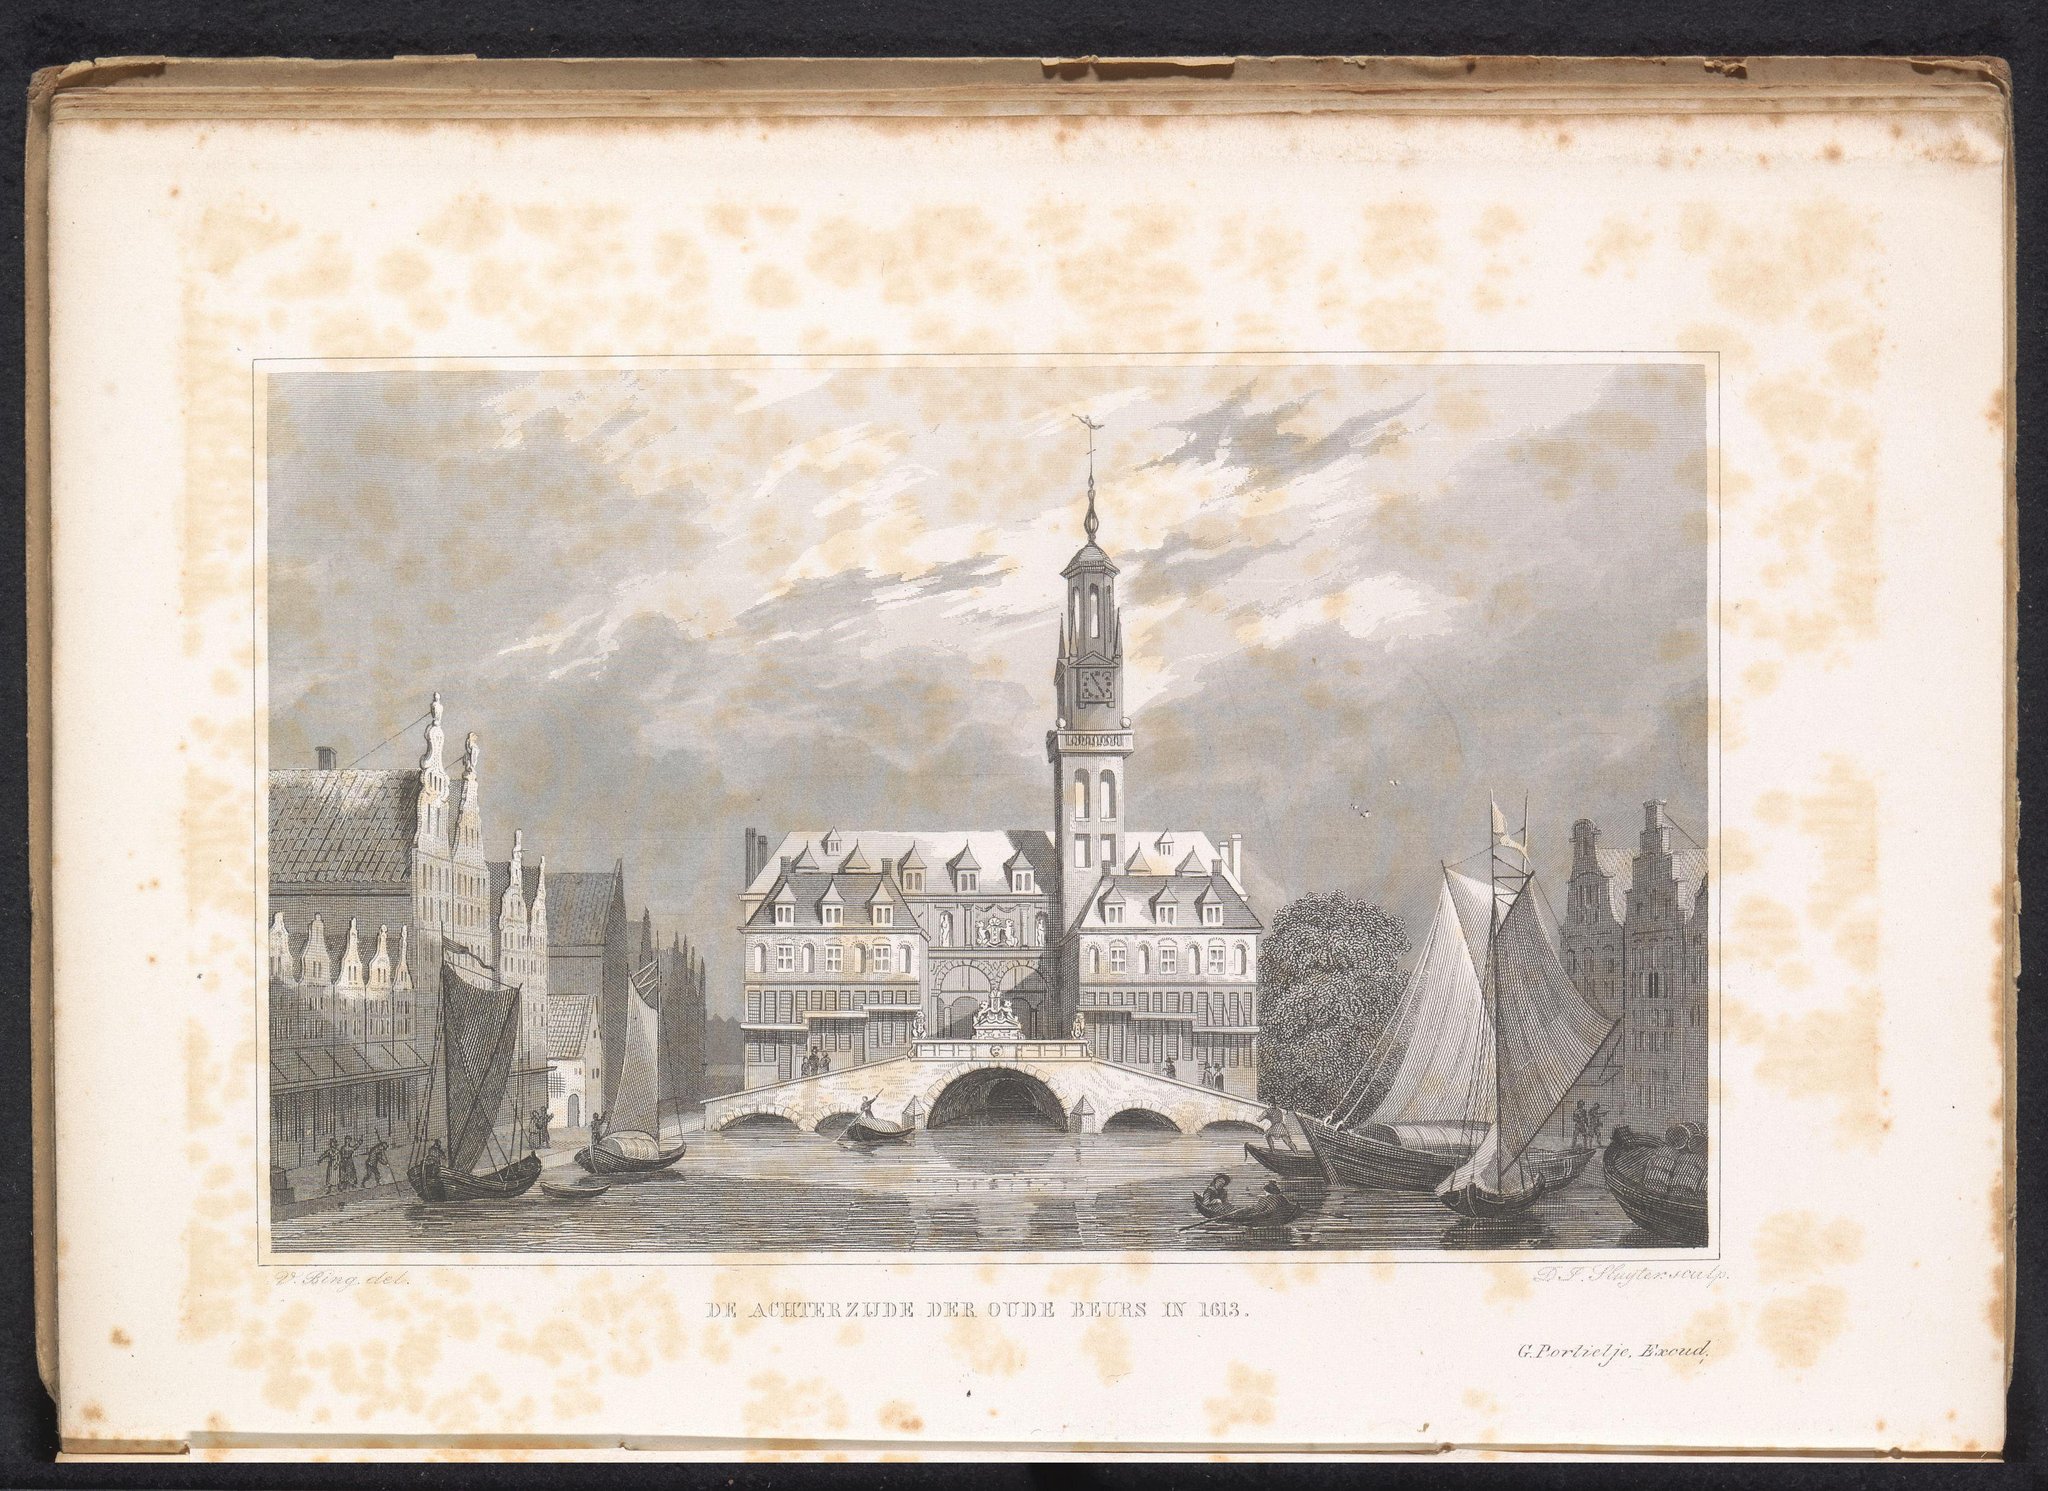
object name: print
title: Gezicht op de achterzijde van de Beurs van Hendrik de Keyser te Amsterdam, 1613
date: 1846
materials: paper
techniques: engraving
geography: netherlands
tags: sailing-ship, sailing-boat, stock exchange, stock-market, canals, waters (in city) (+ city(-scape) with figures, staffage)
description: Gezicht op de achterzijde van de oude beurs van Hendrik de Keyser te Amsterdam in 1613. Illustratie in een boek uit 1846 over de oude en nieuwe beurs van Amsterdam.